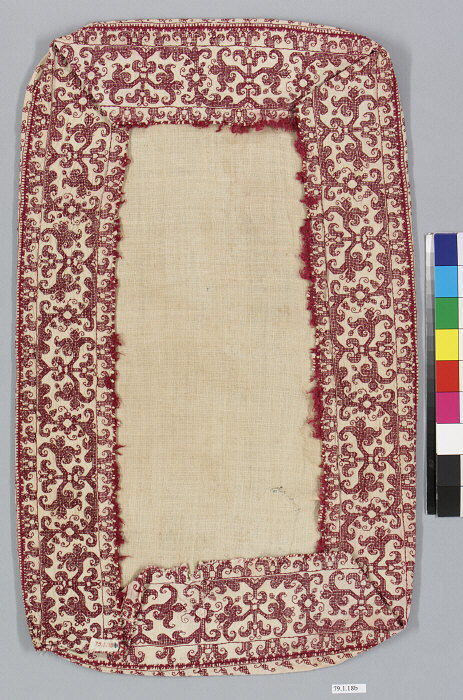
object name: pillow cover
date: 1501-1600